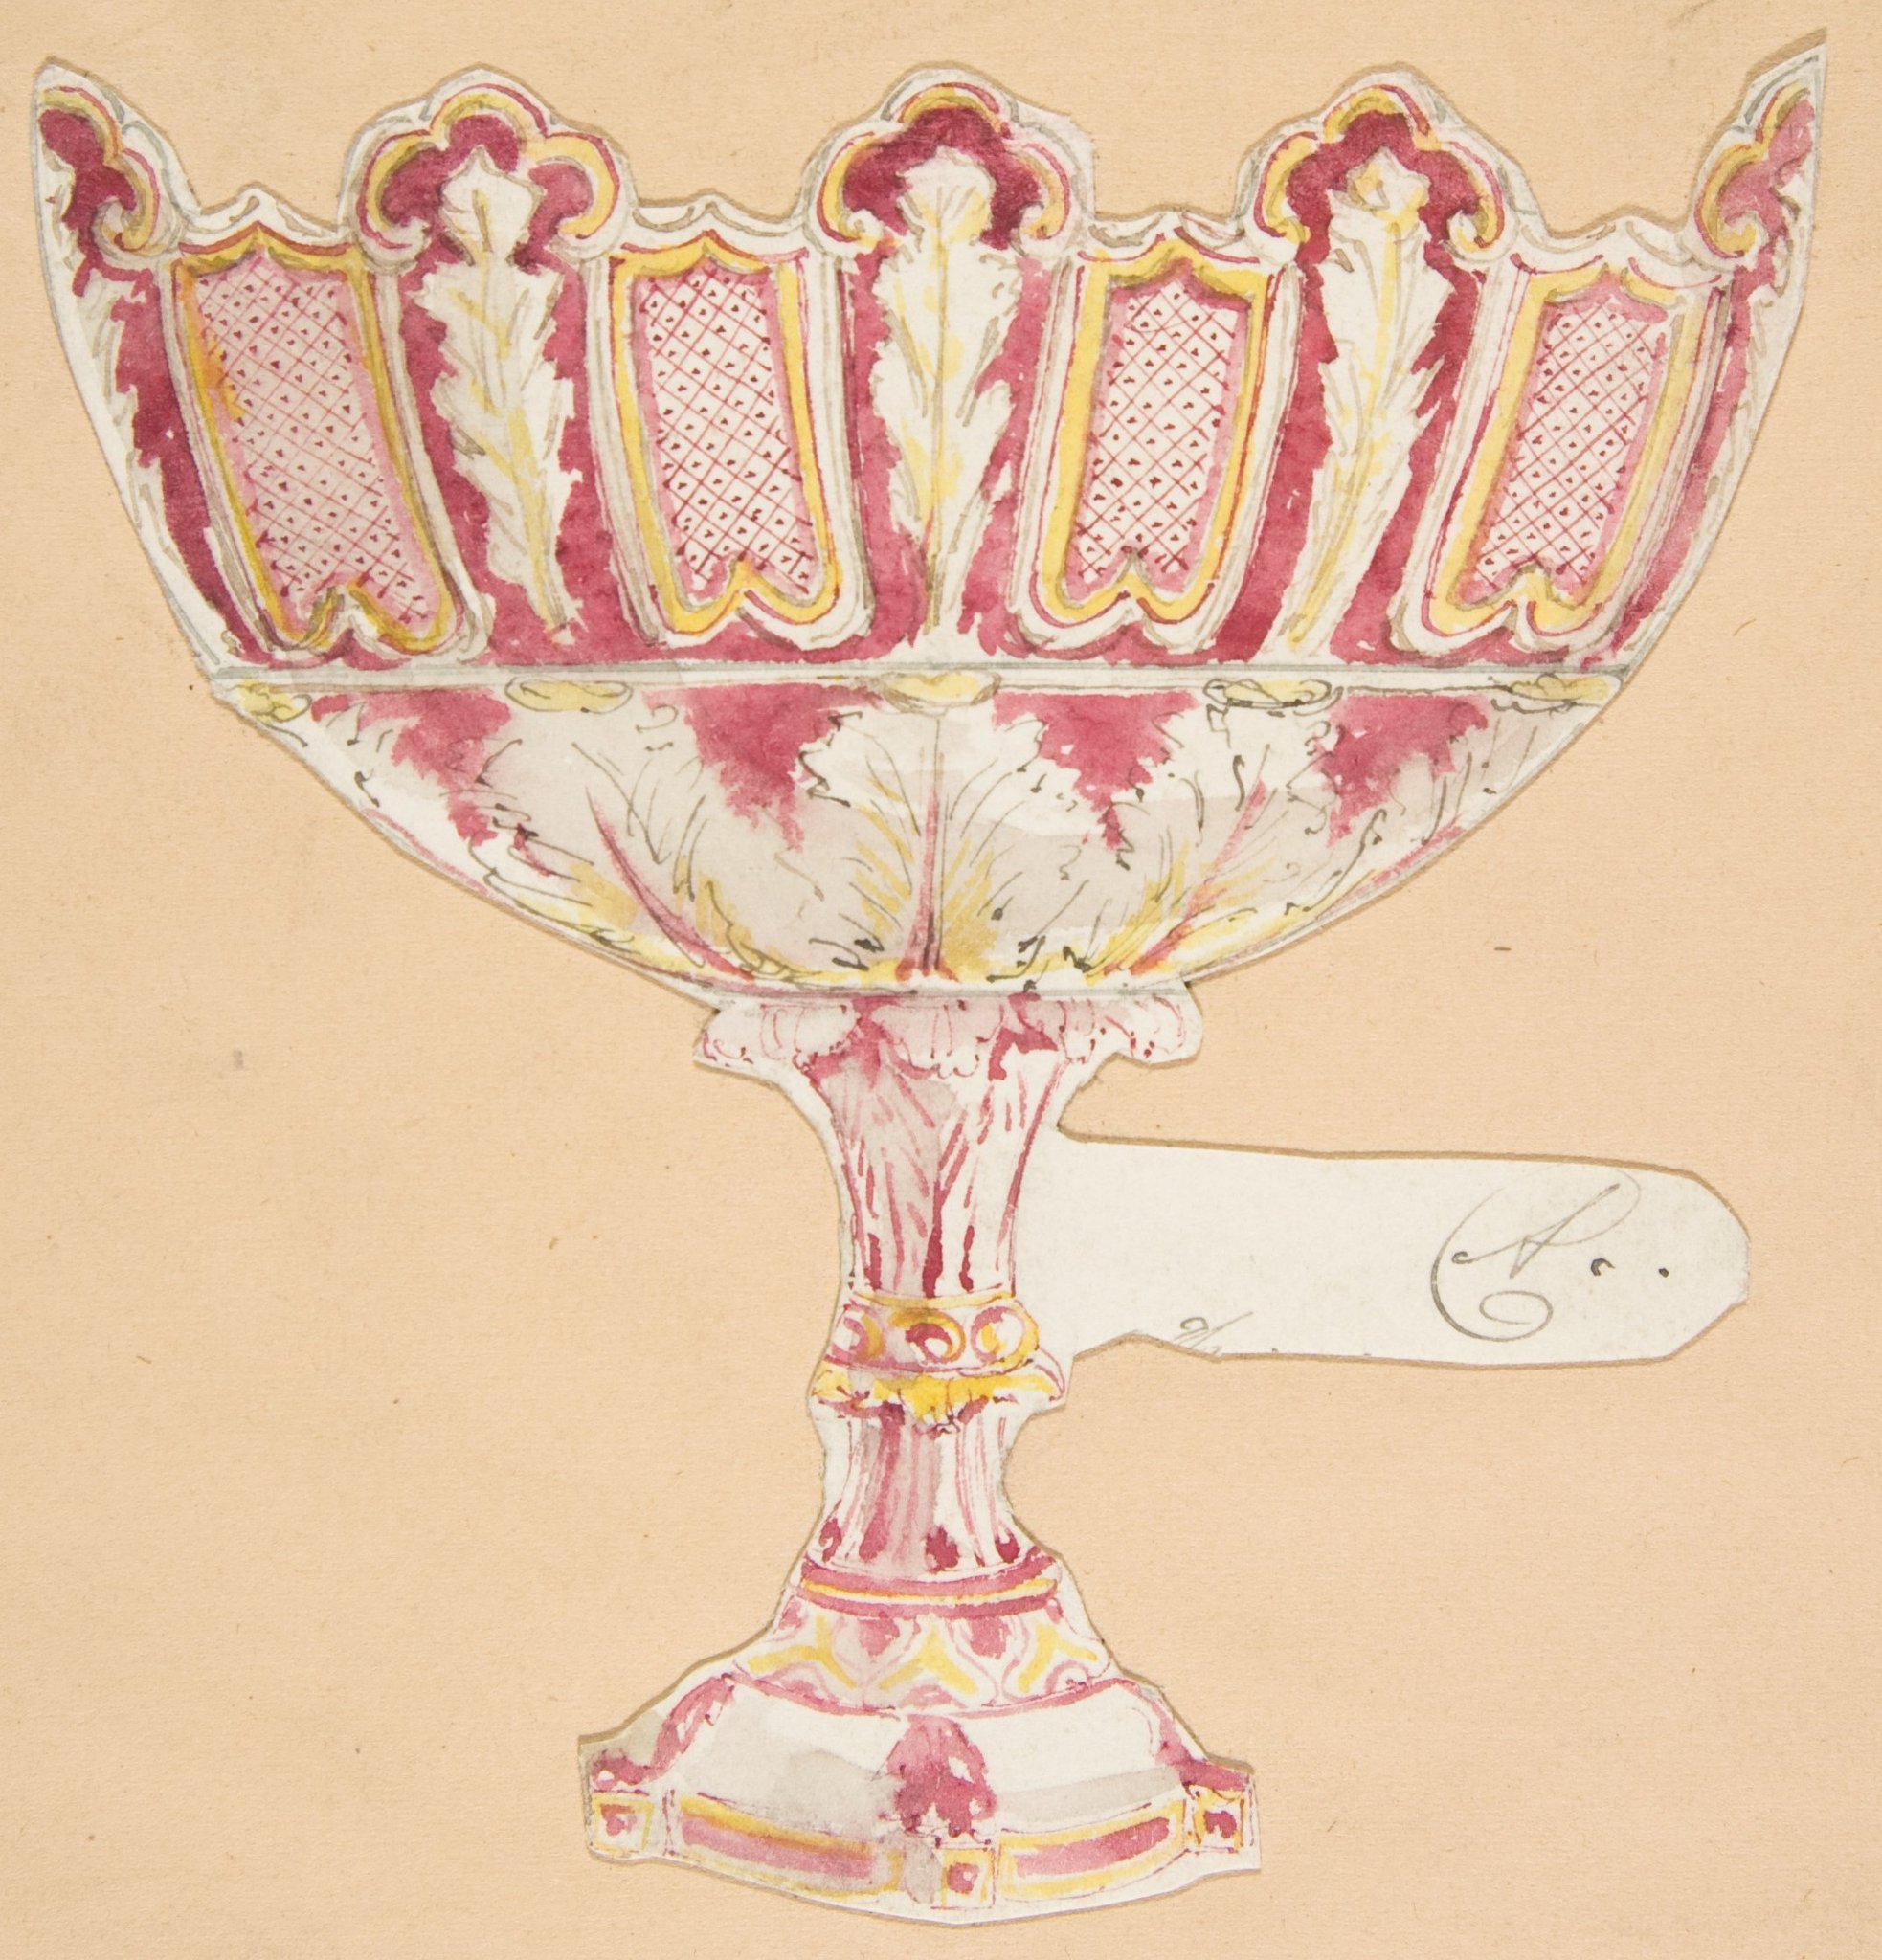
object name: drawing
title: Design for a vessel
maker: anonymous, french, 19th century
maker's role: artist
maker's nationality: french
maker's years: 1800-1900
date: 1801-1900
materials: ink, watercolor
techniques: pen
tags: vessels